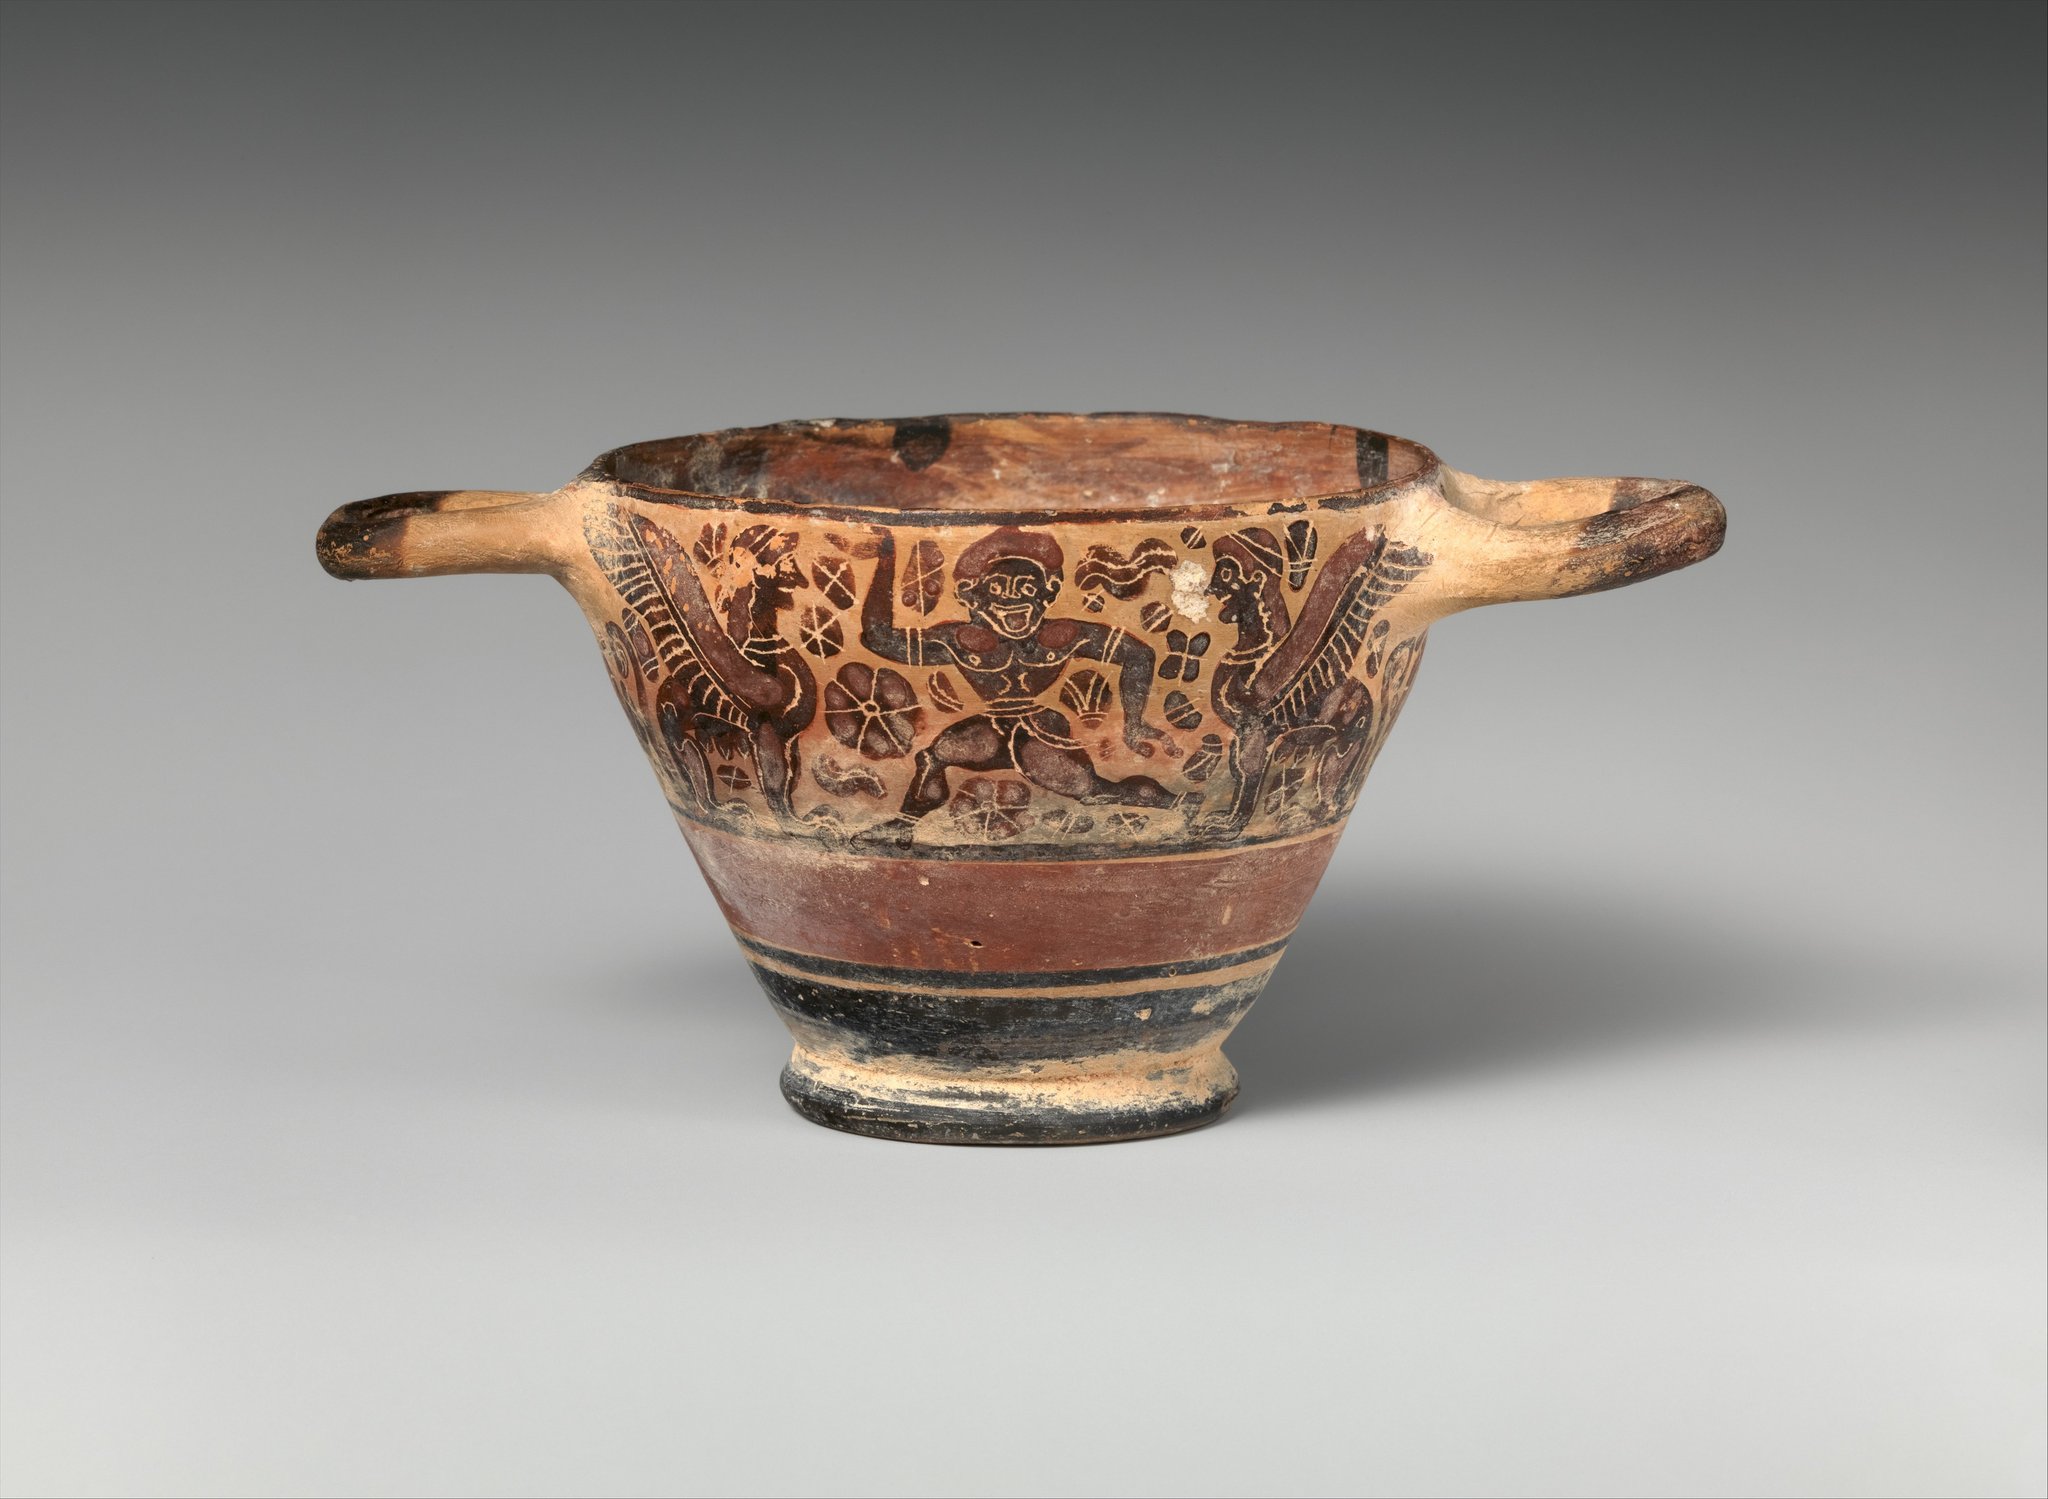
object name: skyphos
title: Terracotta skyphos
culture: etruscan, etrusco-corinthian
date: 600-501 BCE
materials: terracotta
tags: men,sphinx